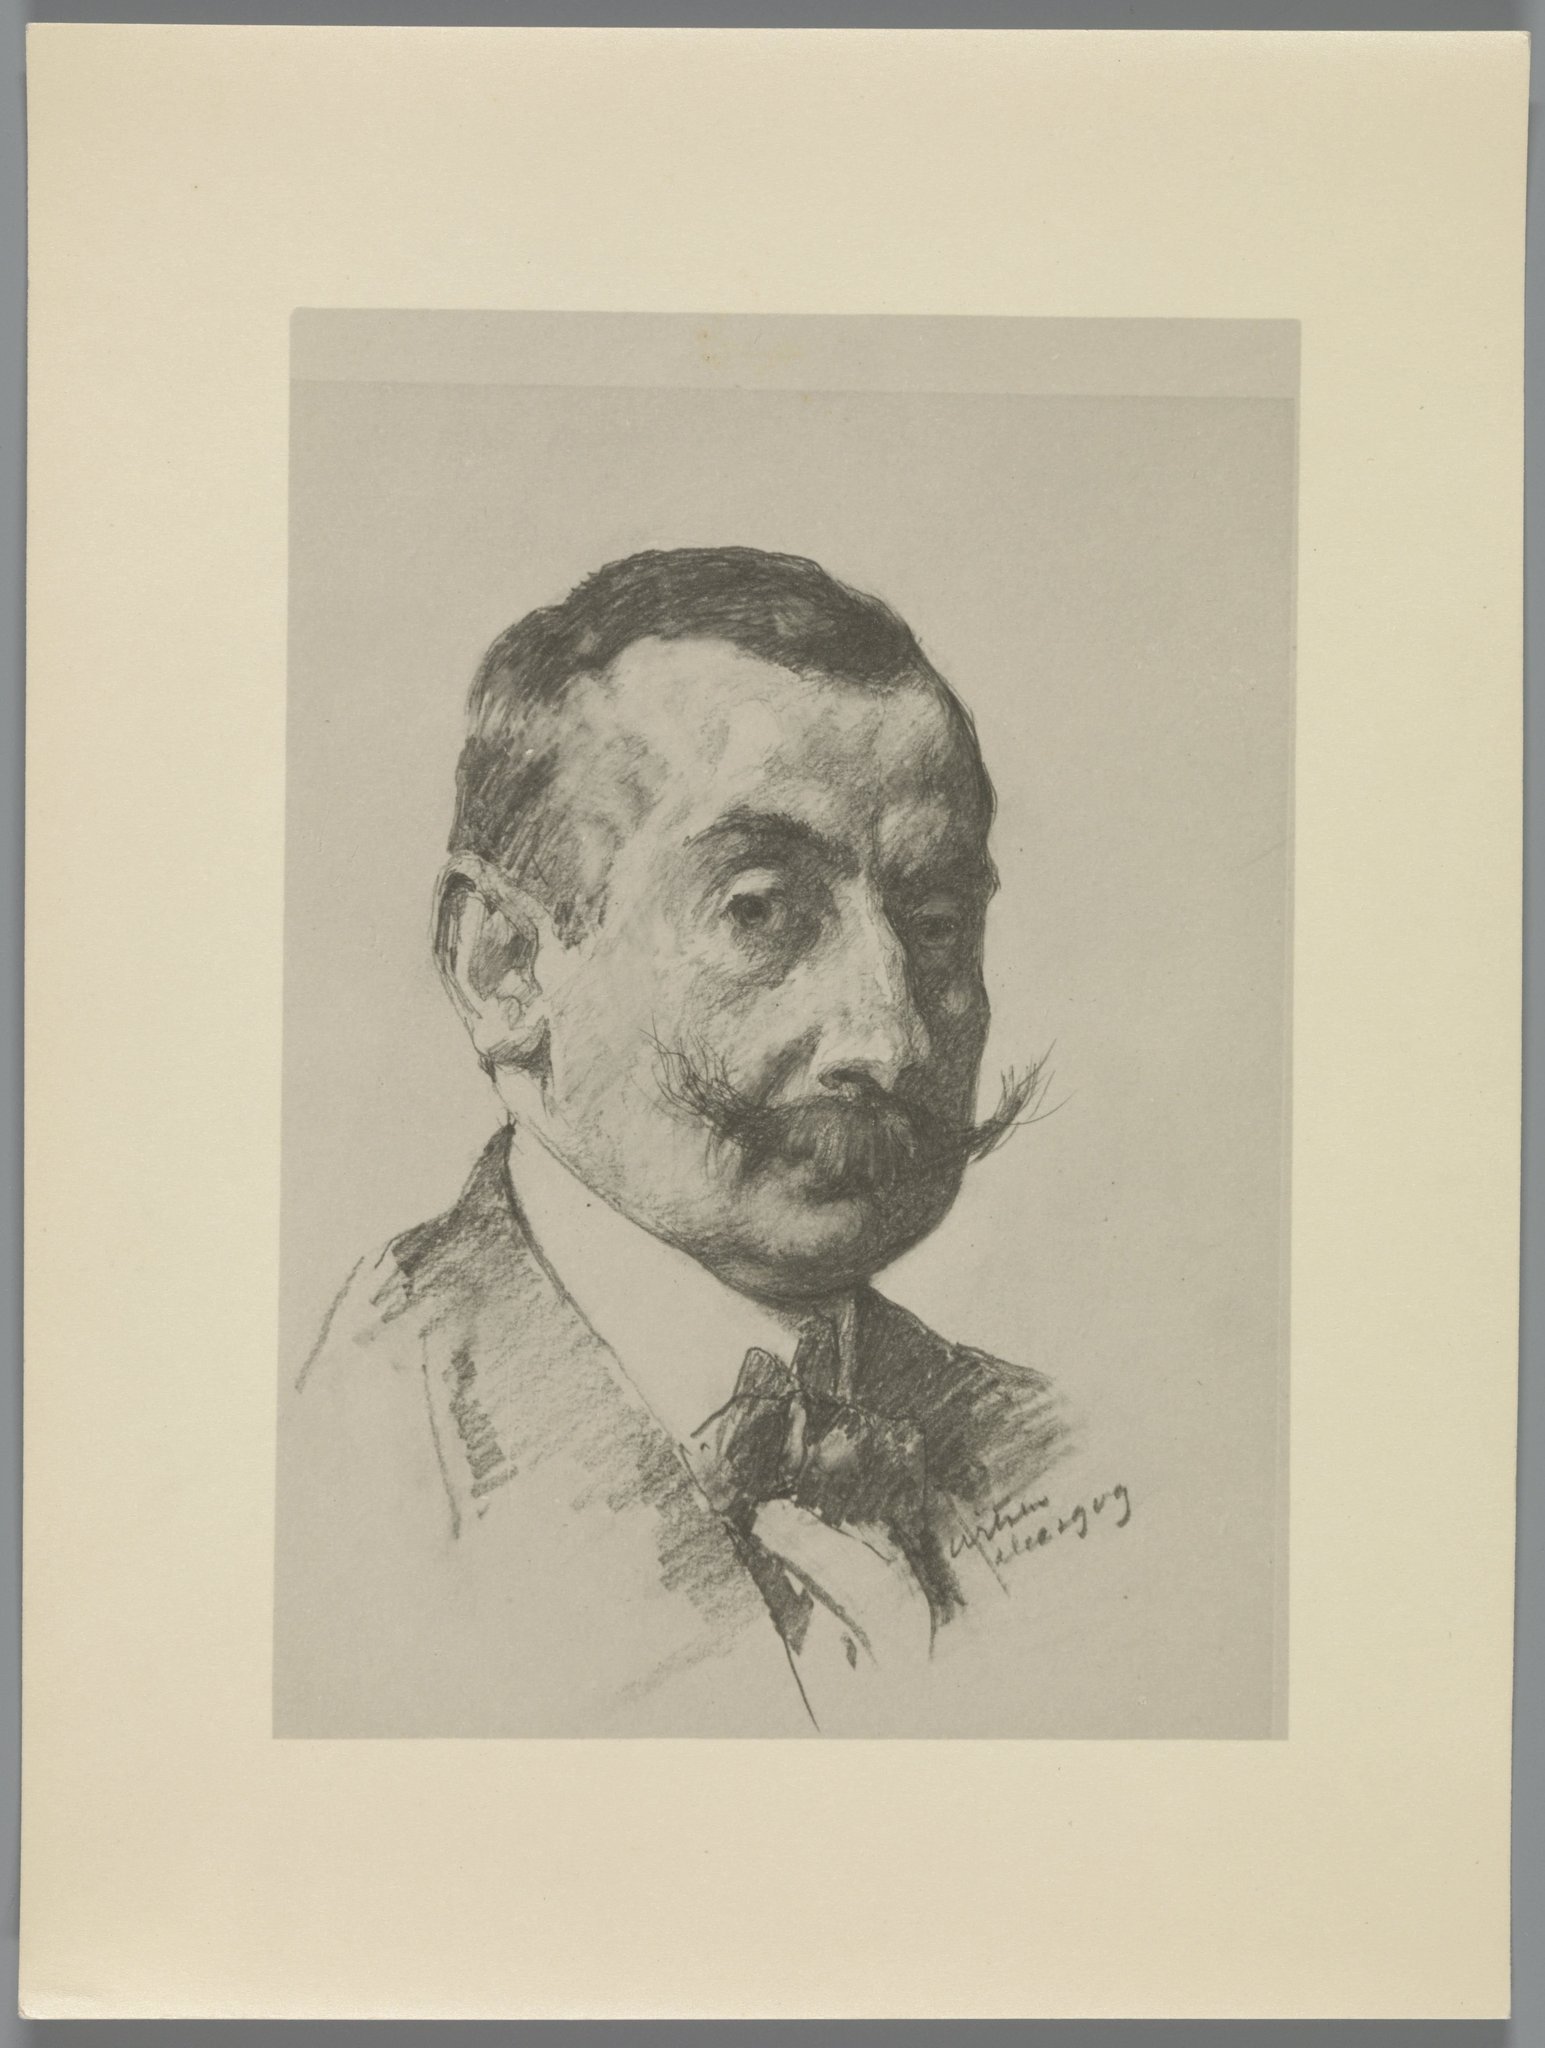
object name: photograph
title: Reproductie naar een foto van Willem Witsen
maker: Anonymous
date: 1860-1915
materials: paper, photographic support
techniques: gelatin silver print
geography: netherlands